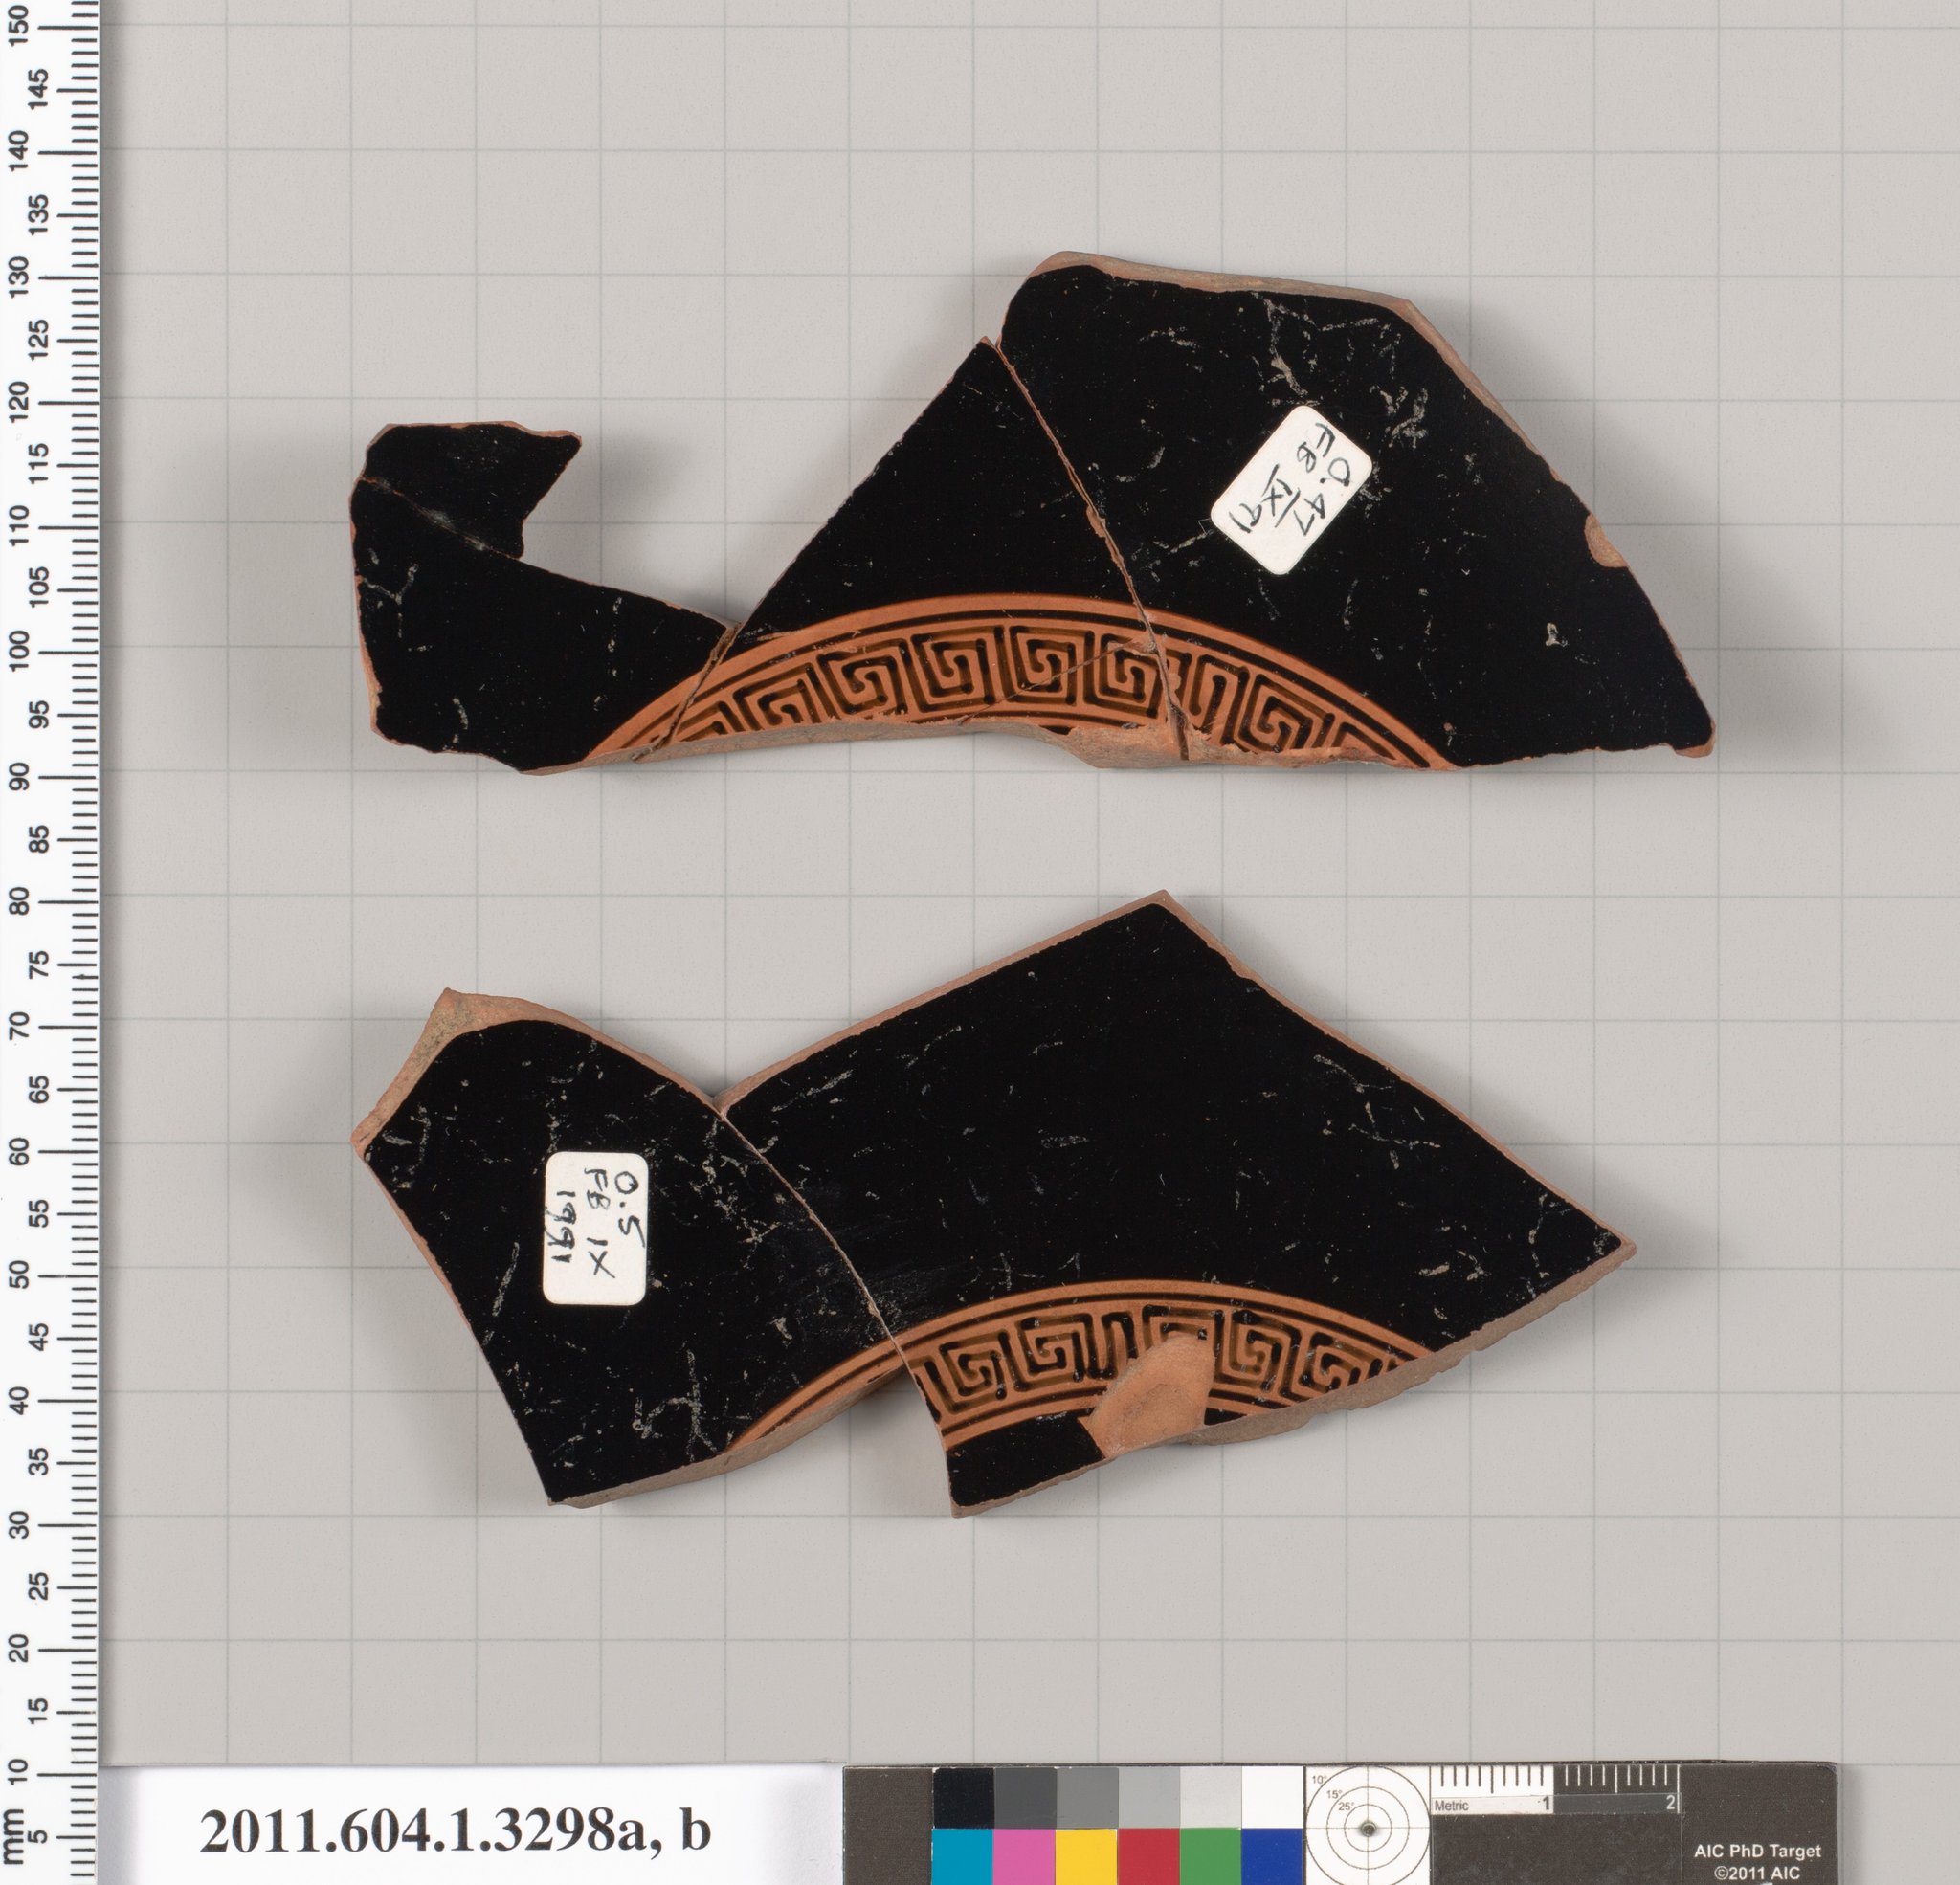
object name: kylix fragment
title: Terracotta fragments of a kylix (drinking cup)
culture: greek, attic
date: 500-480 BCE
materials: terracotta